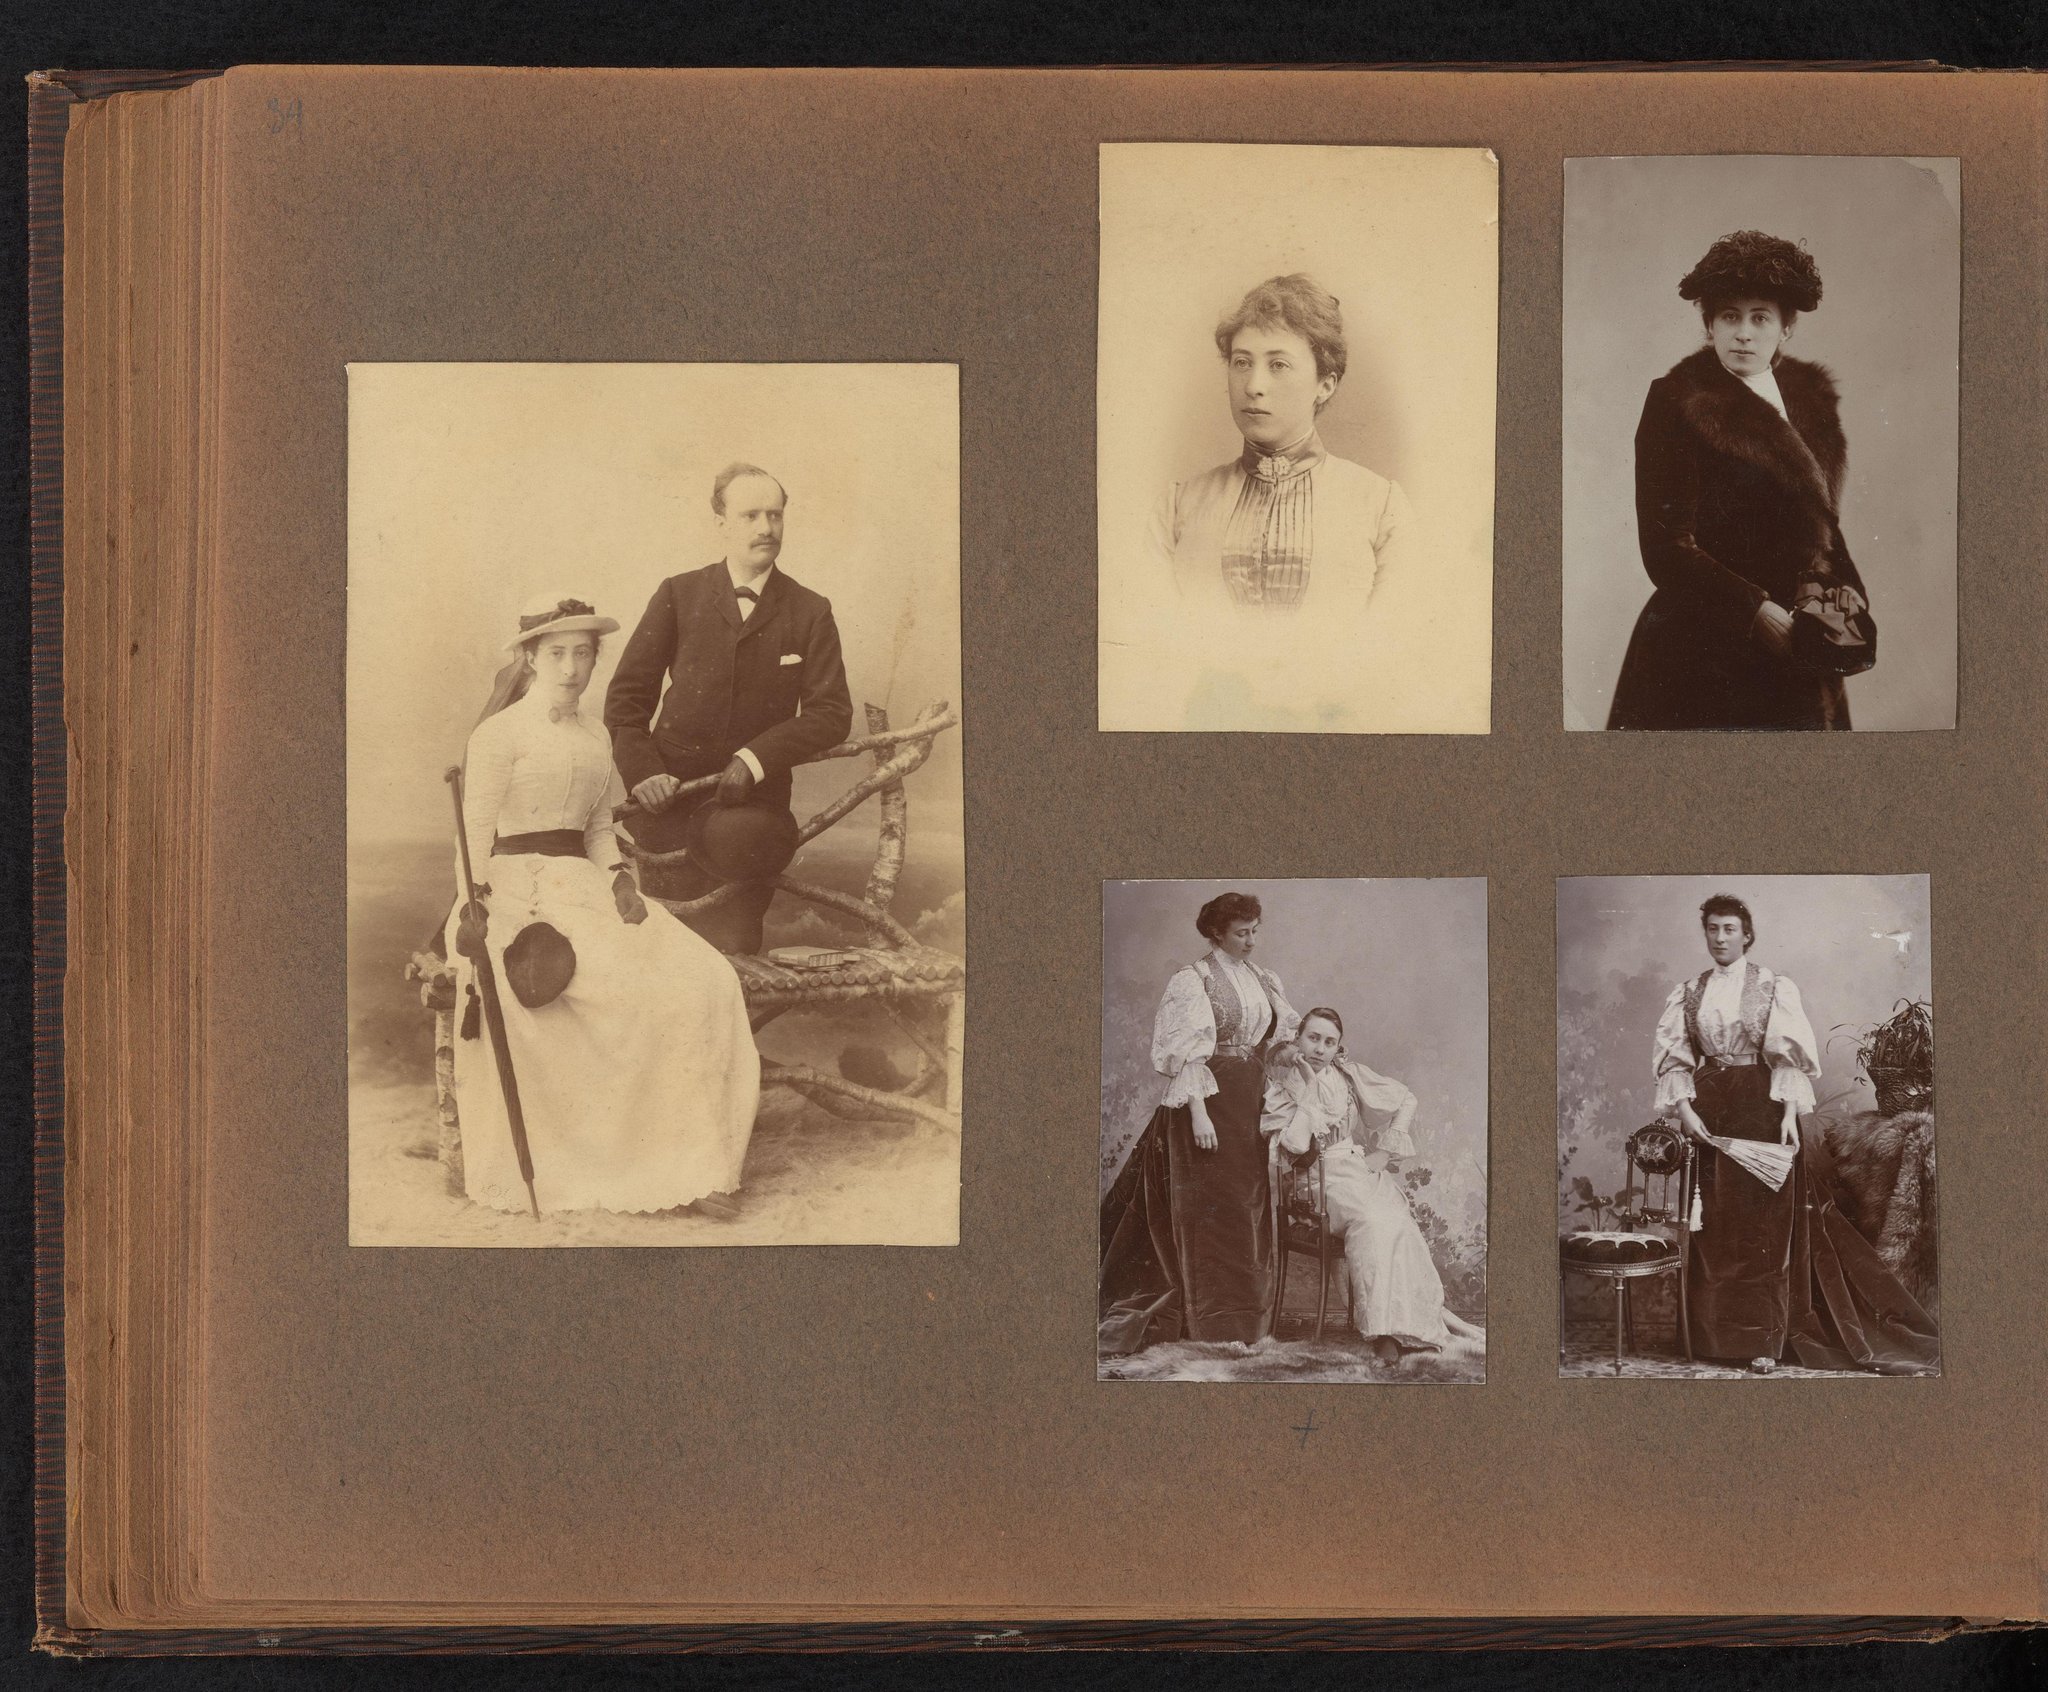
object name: photograph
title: Bladzijde uit het fotoalbum van de familie Diepenbrock met 5 foto's van Alphons Diepenbrock en zijn omgeving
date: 1895-1925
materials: cardboard, photographic support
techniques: photography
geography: amsterdam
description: Bruin albumblad 34 van familiealbum van Alphons Diepenbrock. Bladzijde uit het fotoalbum van de familie Diepenbrock met portretten van zus Cécile, onder andere met portretten van Cécile en haar echtgenoot en van Cécile en Elsa.